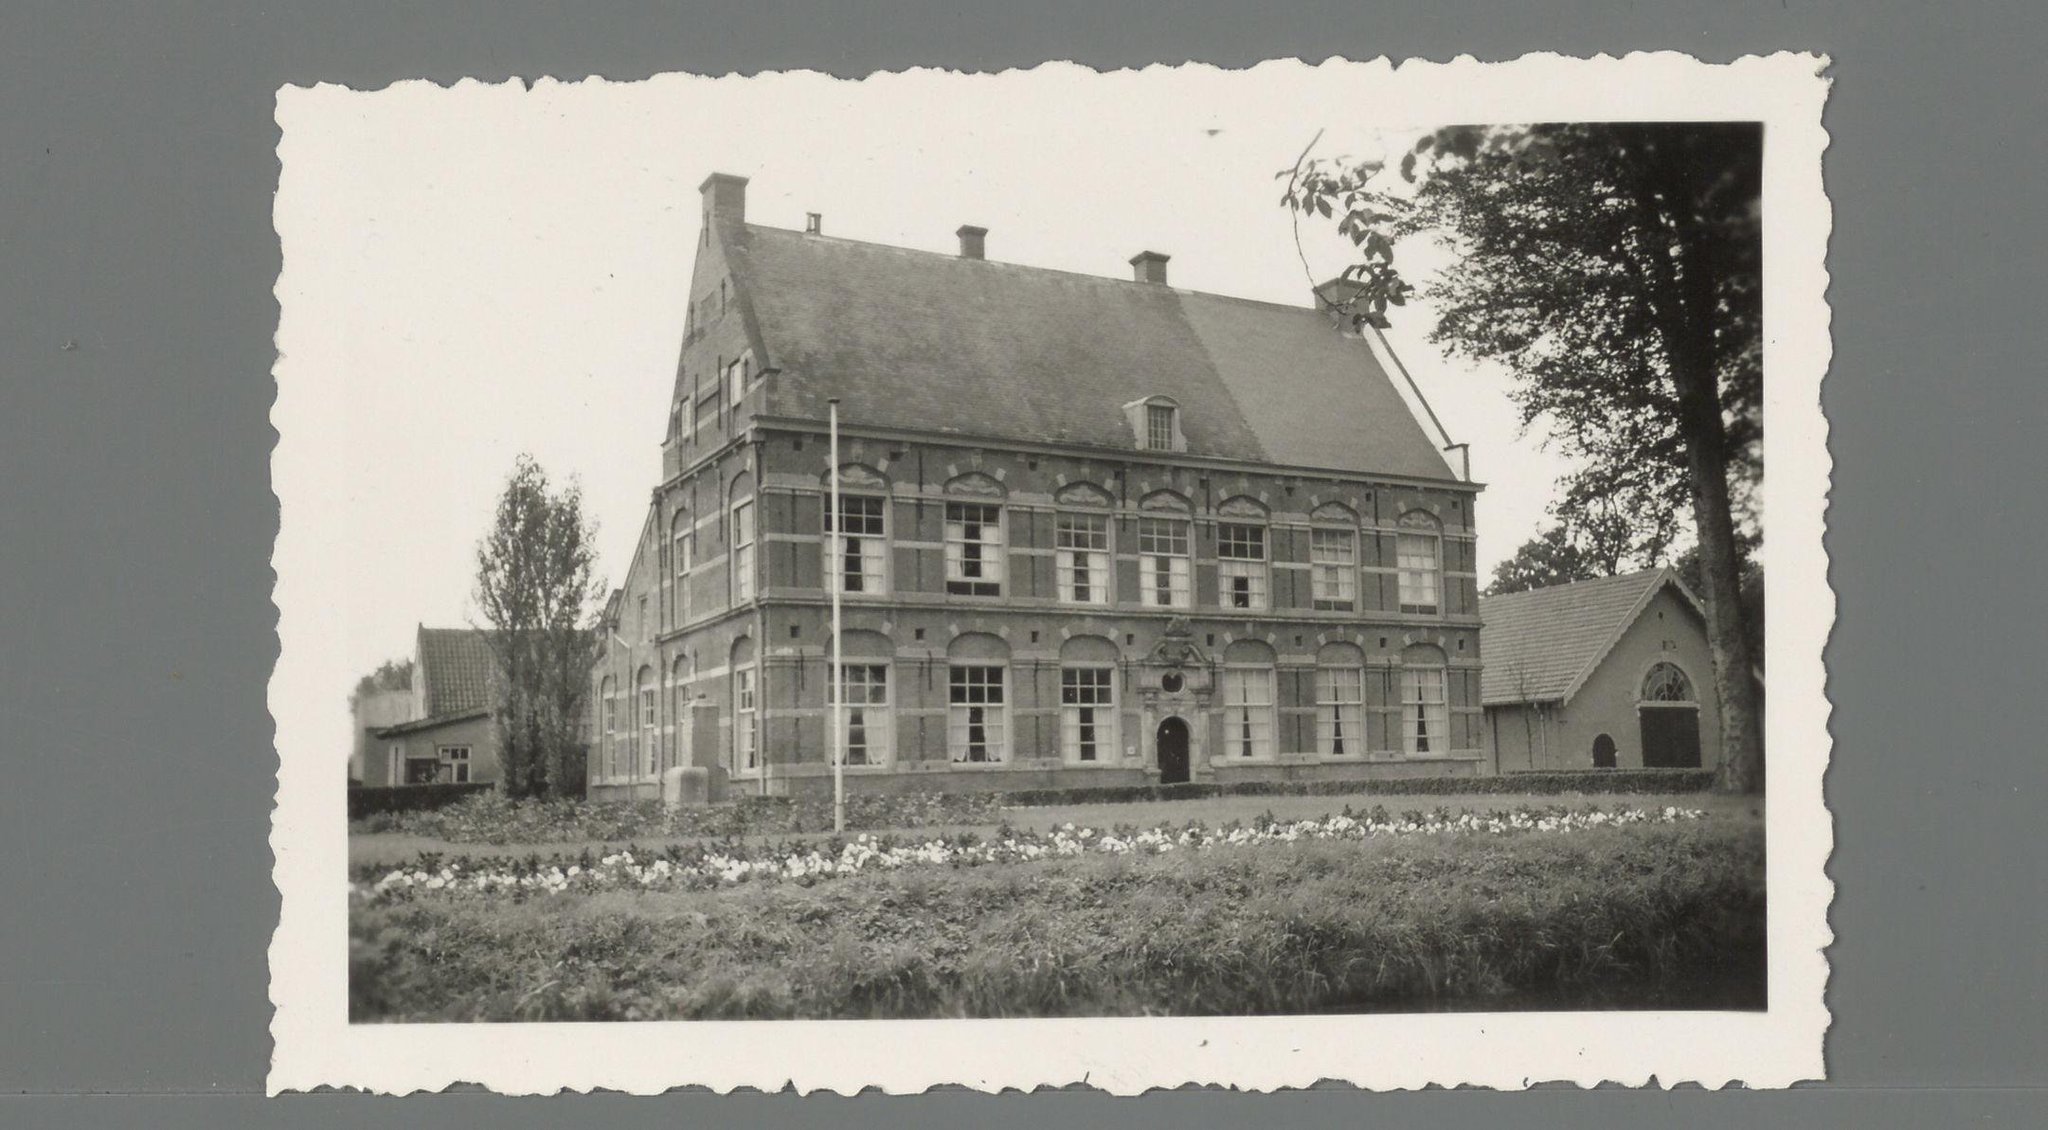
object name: photograph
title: Gezicht op het Mauritshuis in Willemstad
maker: Anonymous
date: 1954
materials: paper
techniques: gelatin silver print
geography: willemstad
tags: façade (of house or building)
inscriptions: inscription: ‘Willemstad Jacht[...] prins Maurits 1954’, factory mark: ‘Velox’